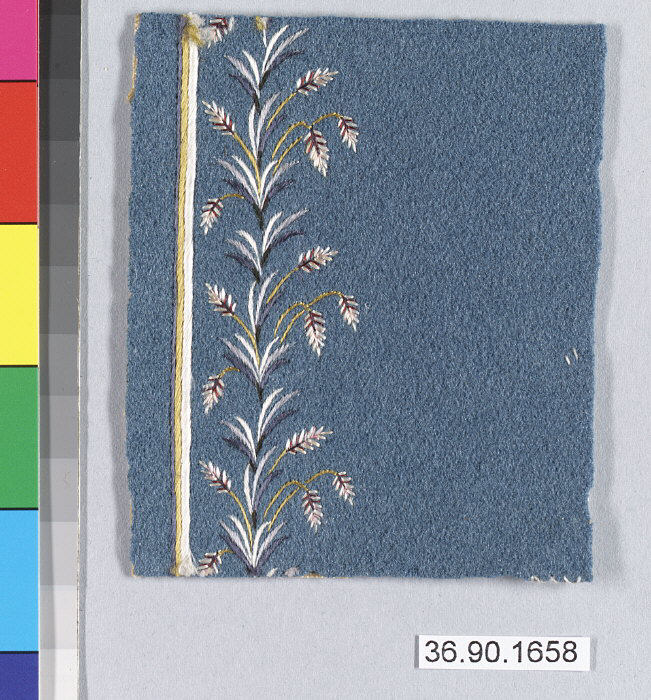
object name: sample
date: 1801-1833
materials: felt, silk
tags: plants